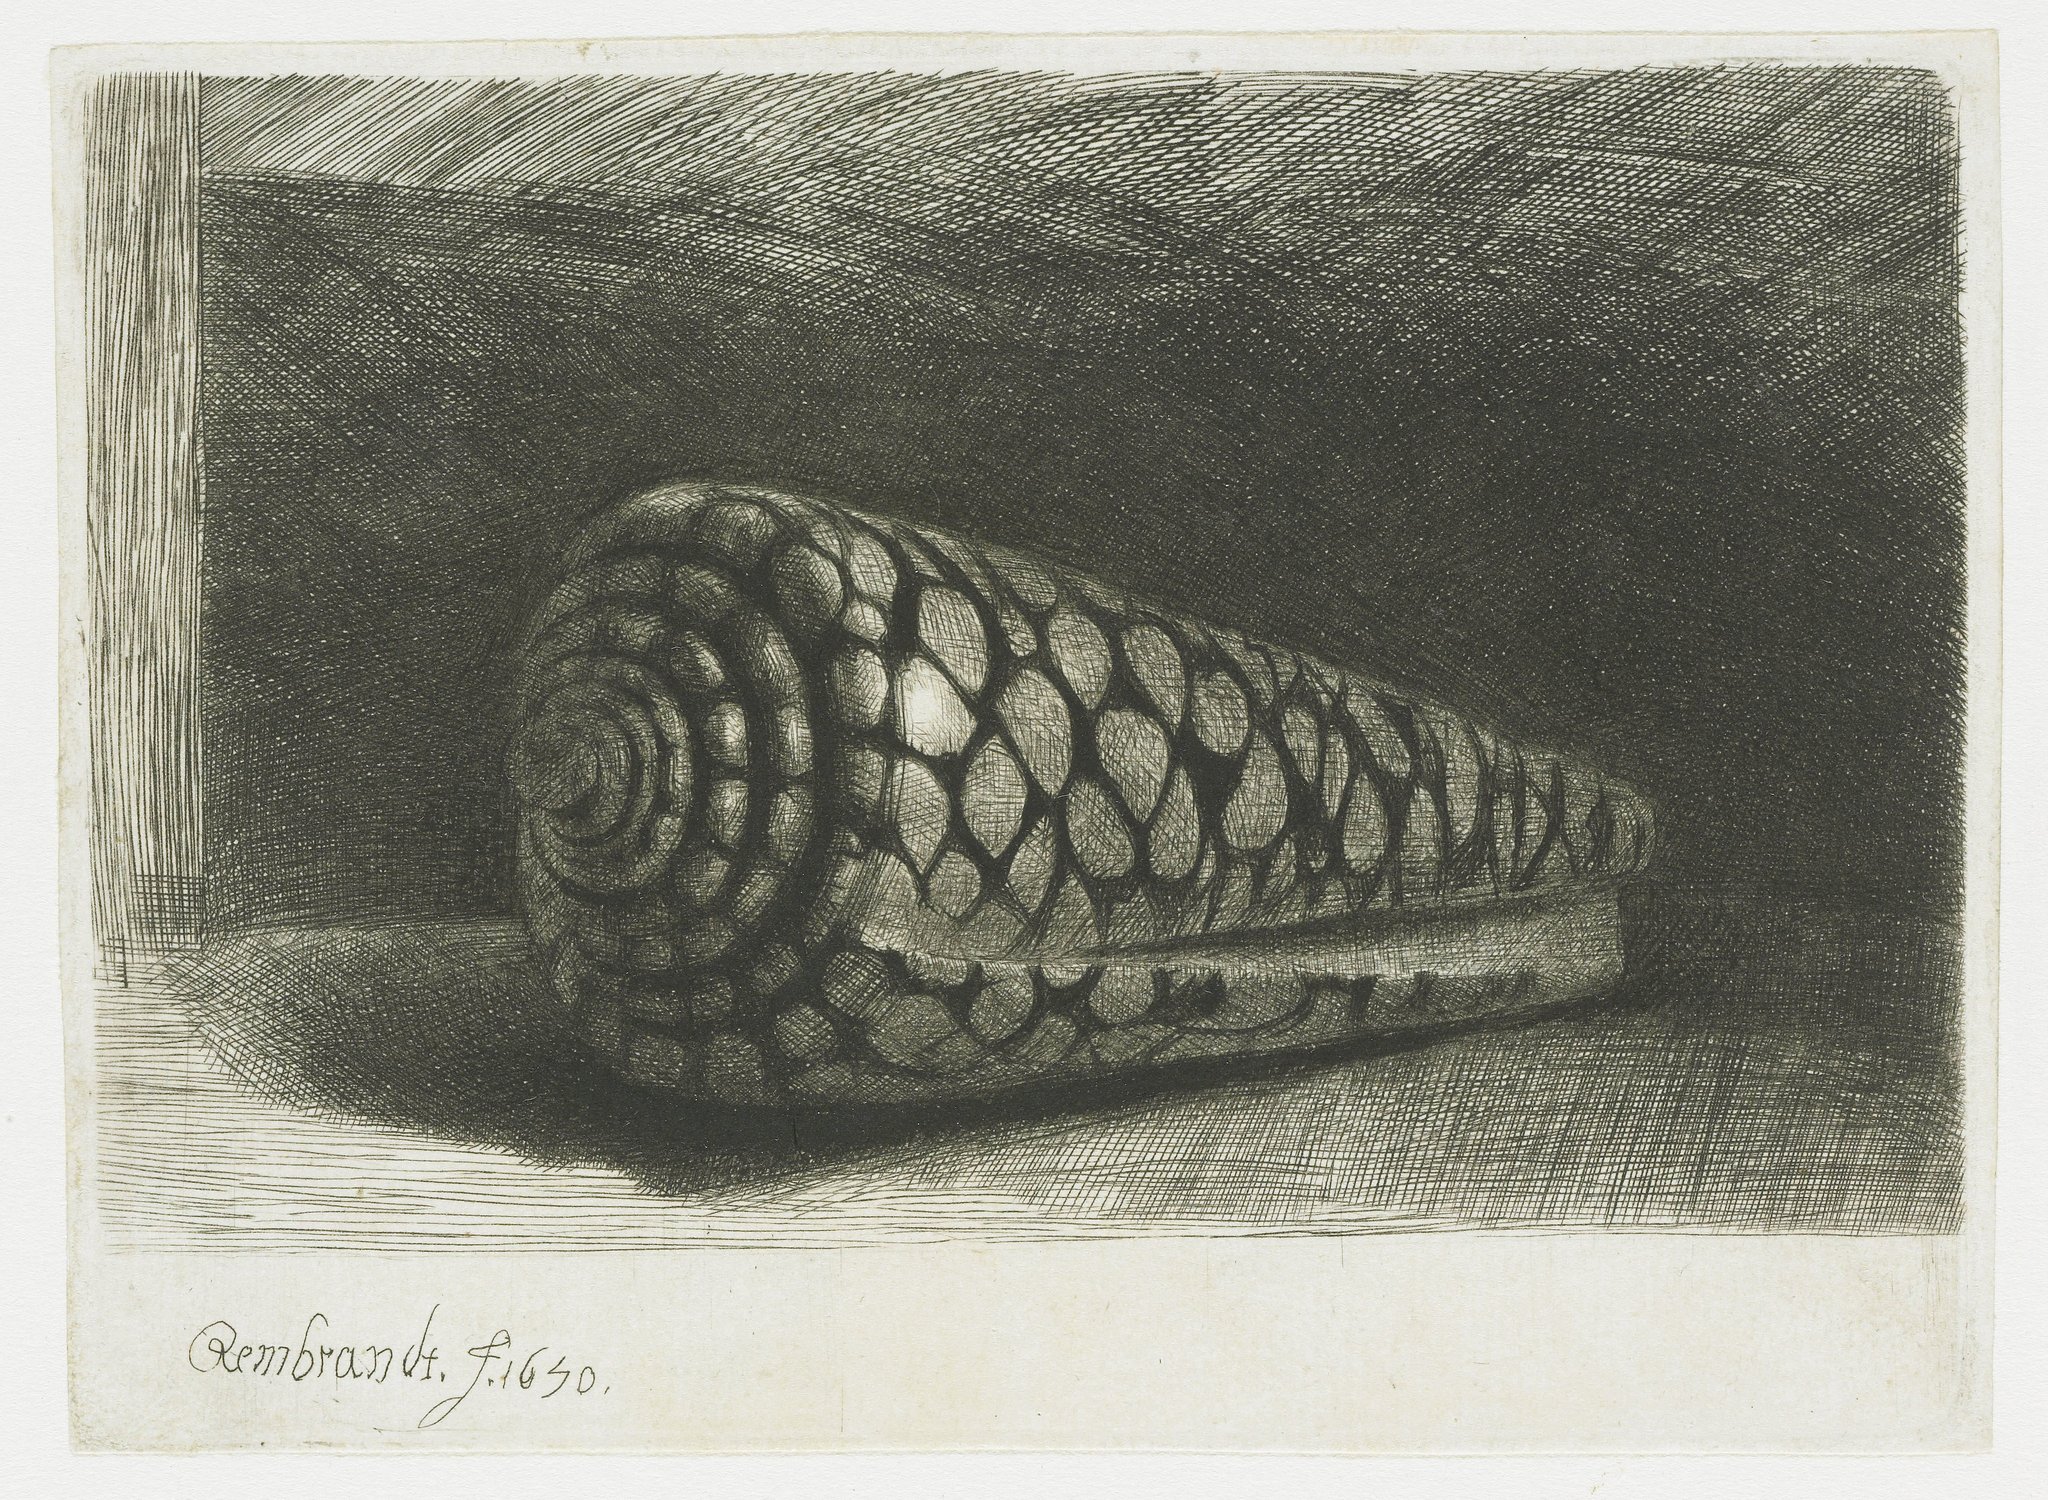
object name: print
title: The shell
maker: rembrandt van rijn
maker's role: draughtsman, painter, print maker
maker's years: 1606-1669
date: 1650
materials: paper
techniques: drypoint, etching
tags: molluscs (+ shell, snail-shell etc.)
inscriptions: signature and date: ‘Rembrandt f 1650’, mark: Lugt 2228